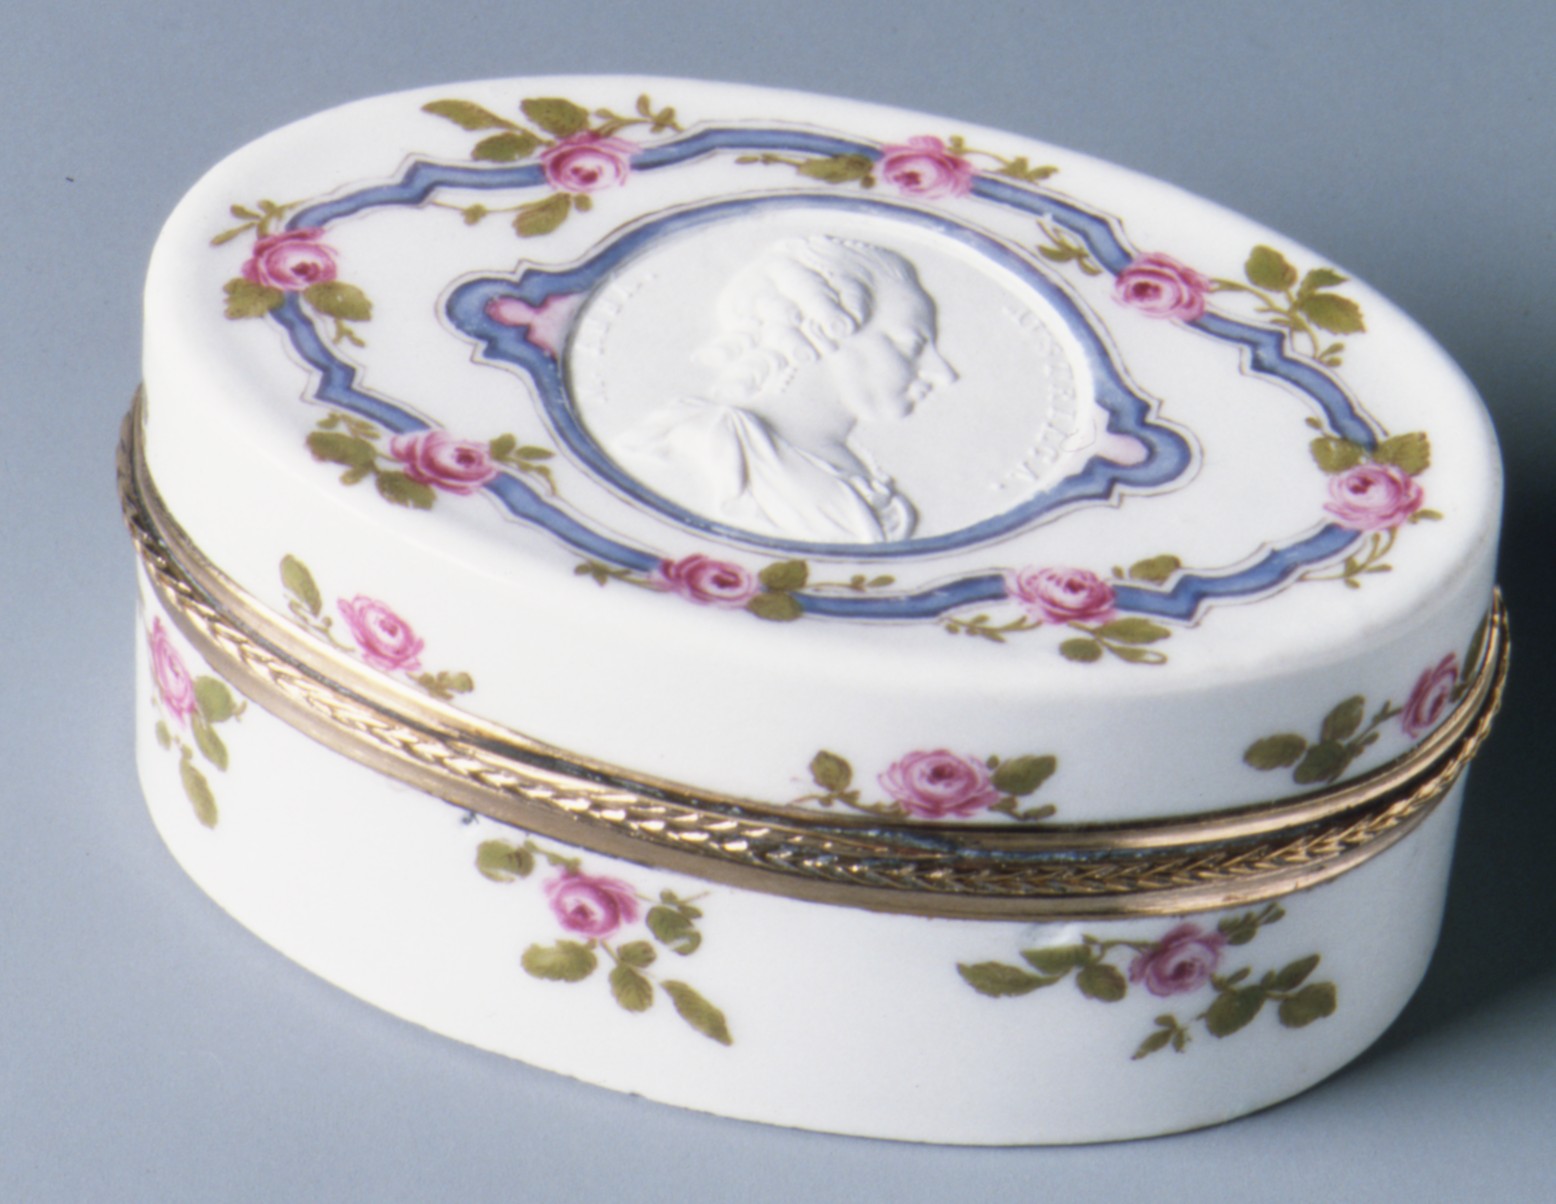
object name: snuffbox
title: Snuffbox with portrait of Archduchess Maria Anna of Austria (1738–89)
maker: fürstenberg porcelain manufactory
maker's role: manufactory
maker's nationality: german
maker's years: 1747-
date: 1770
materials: gold, hard paste porcelain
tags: profiles,roses